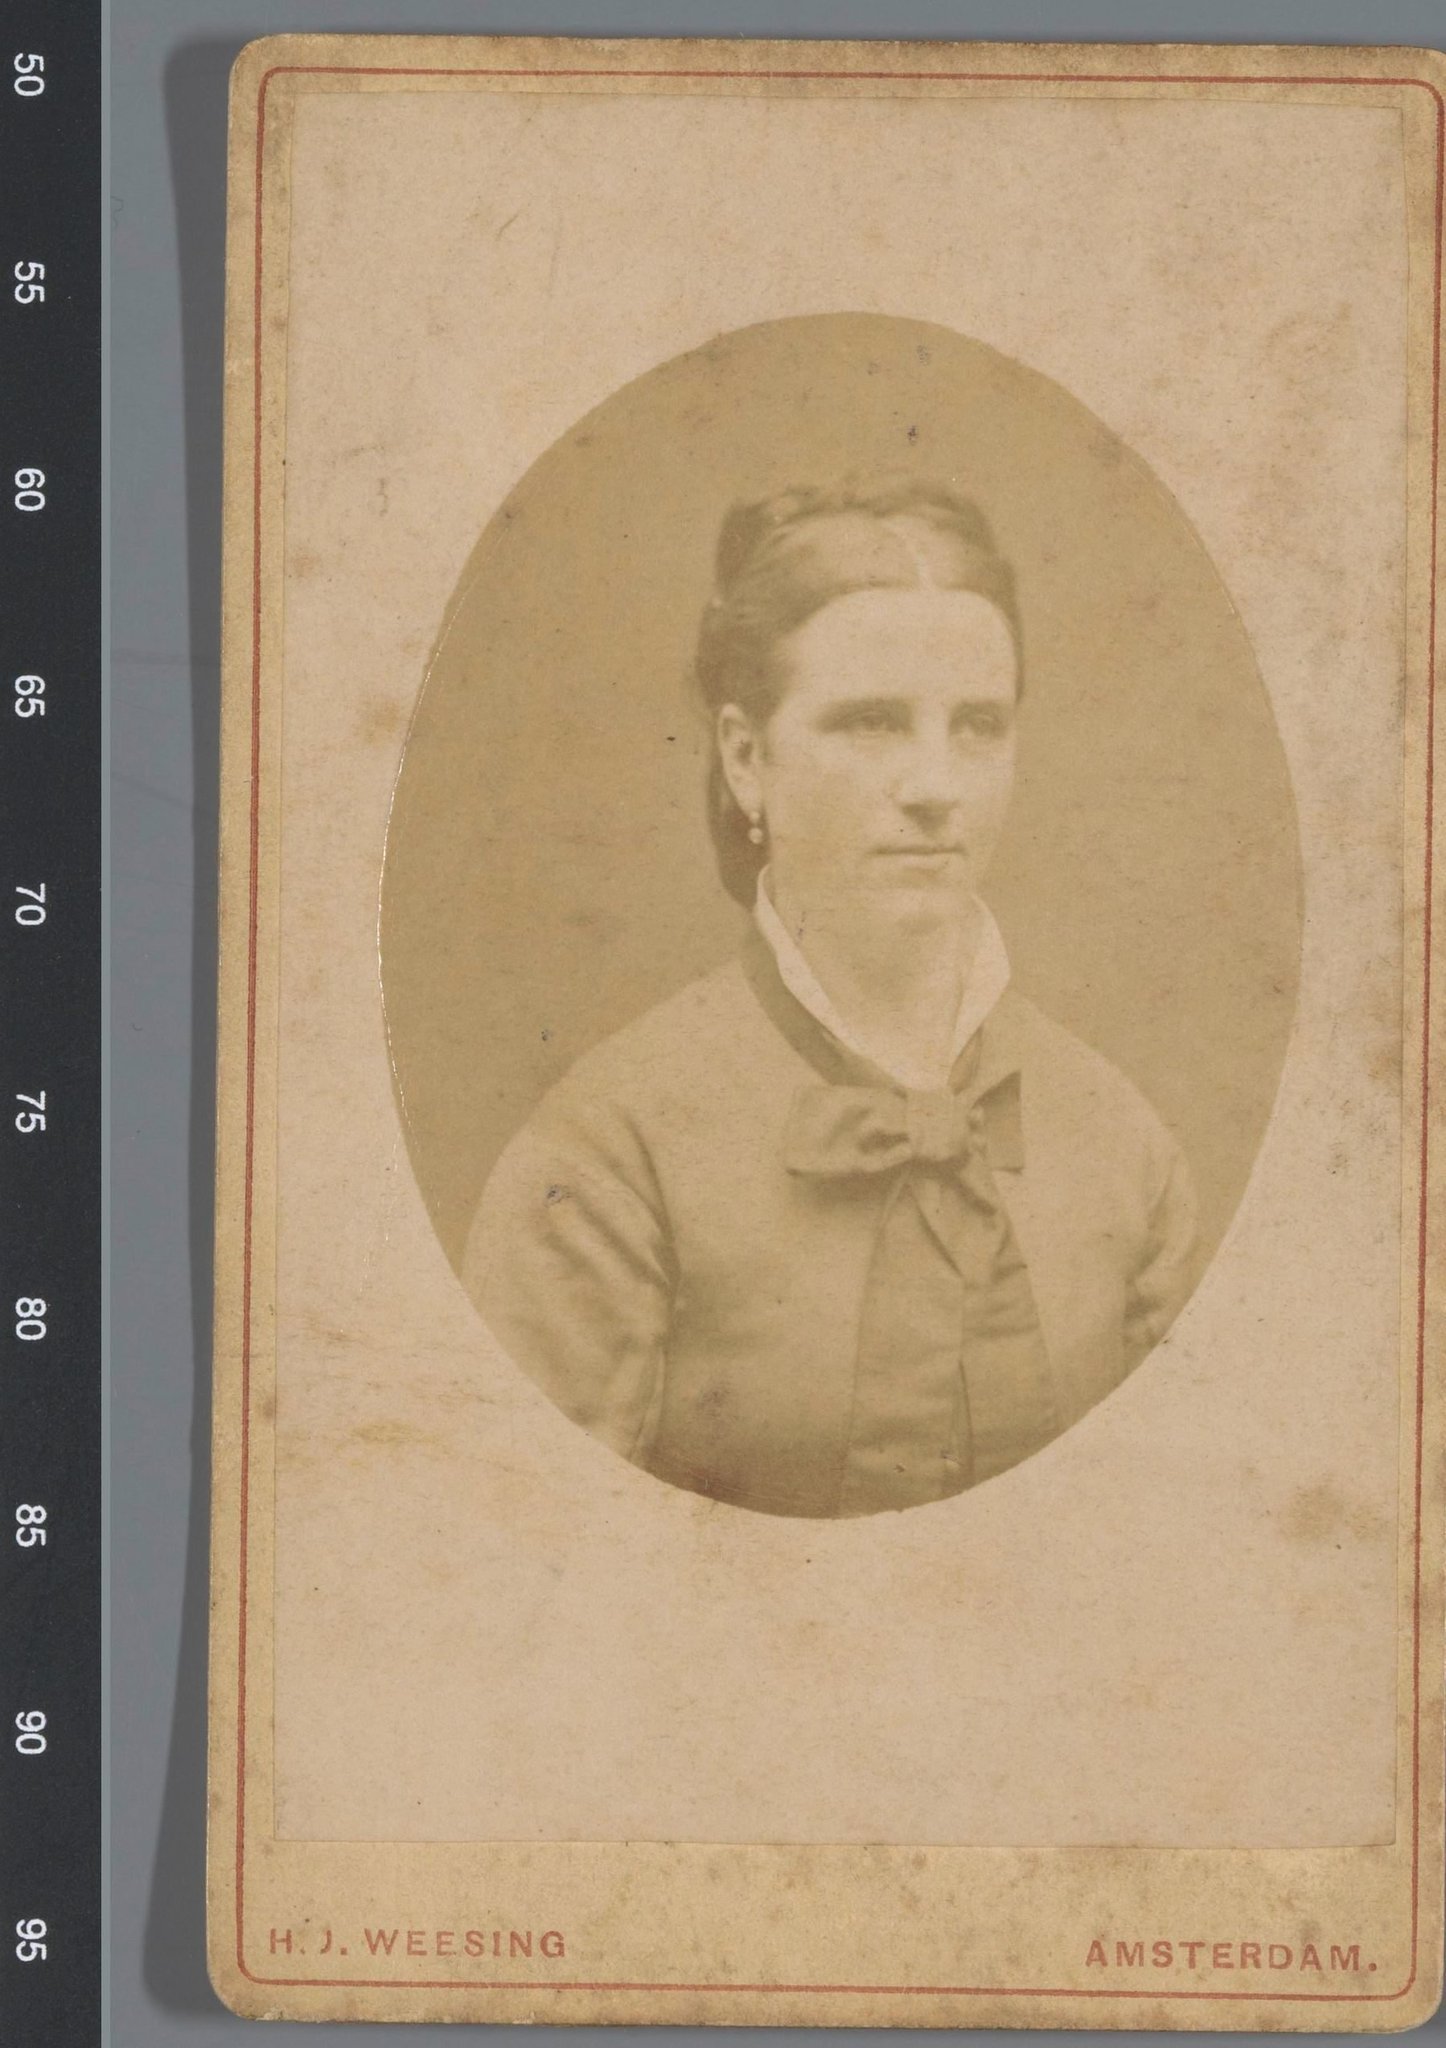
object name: carte de visite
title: Portret van een onbekende vrouw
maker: hermanus jodocus weesing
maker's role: fotograaf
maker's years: 1844-1910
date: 1880-1900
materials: cardboard, paper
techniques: albumen print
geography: amsterdam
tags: historical persons - bb - woman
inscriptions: inscription: ‘HJW/ Photographisch Atelier/ van/ H. J. WEESING/ AMSTERDAM/ 5 Binnen Brouwerstraat 5./ Voor nabestelling worden de platen bewaard.’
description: De geportretteerde vrouw is ook afgebeeld op RP-F-F21964.